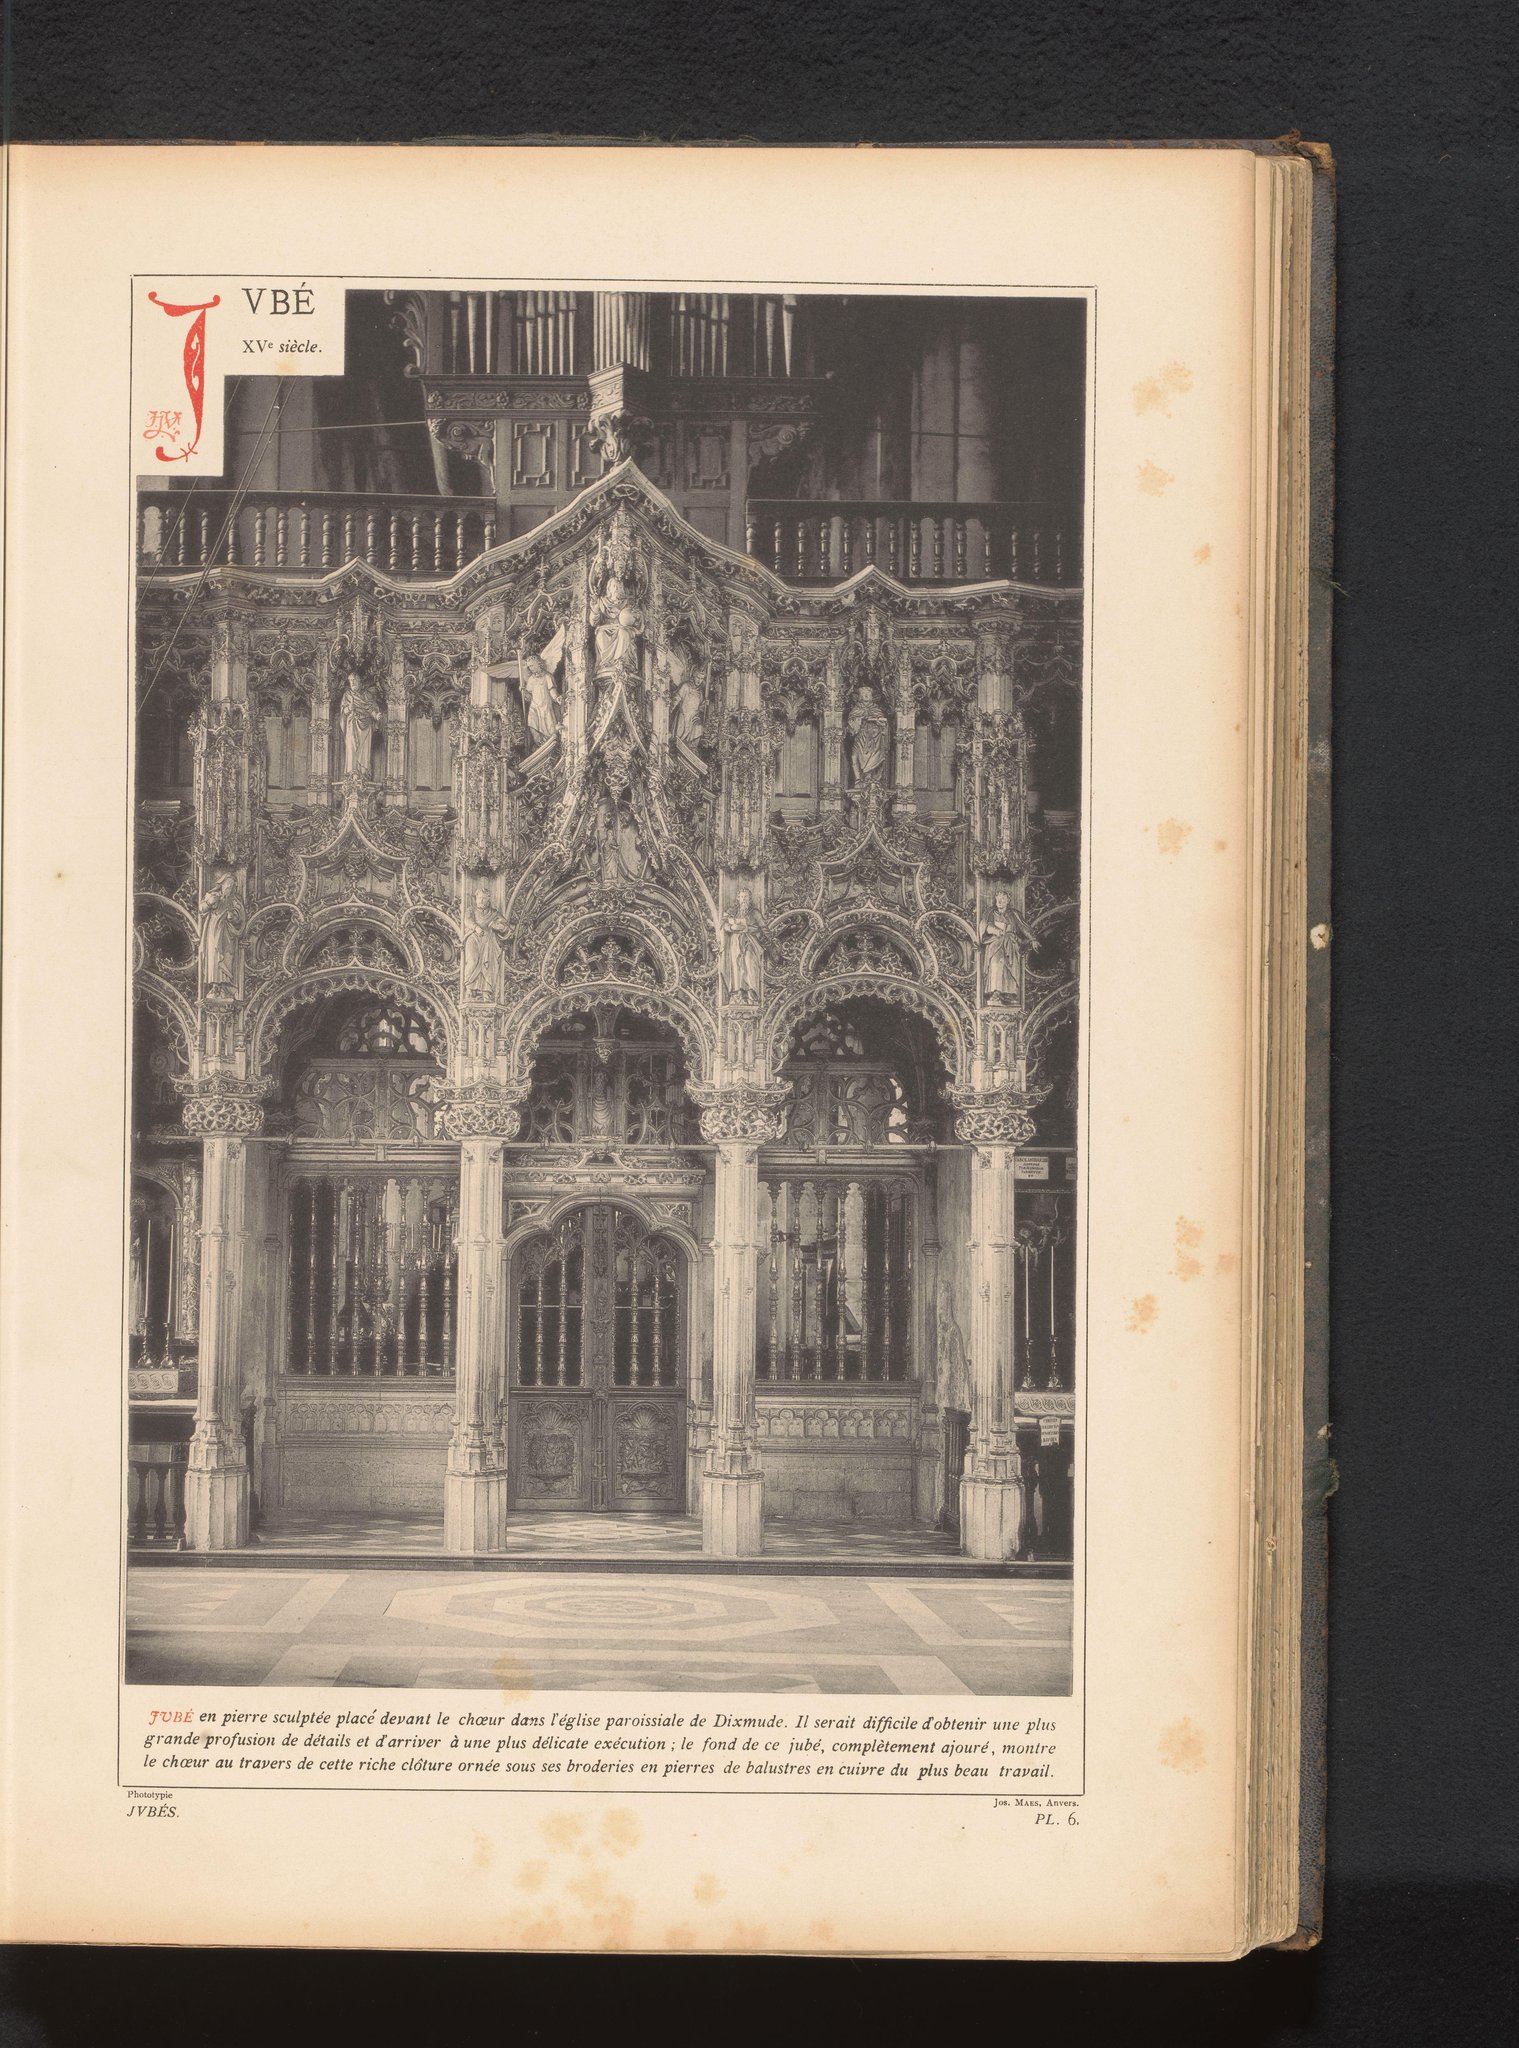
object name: photomechanical print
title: Jubé, XVe siècle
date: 1882-1887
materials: paper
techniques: photograph, photolithography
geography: diksmuide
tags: parts of church interior: choir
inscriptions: inscription: ‘JUBÉS. - PL. 6.’, inscription: ‘JUBÉ en pierre (...)’, monogram: ‘JJvY’